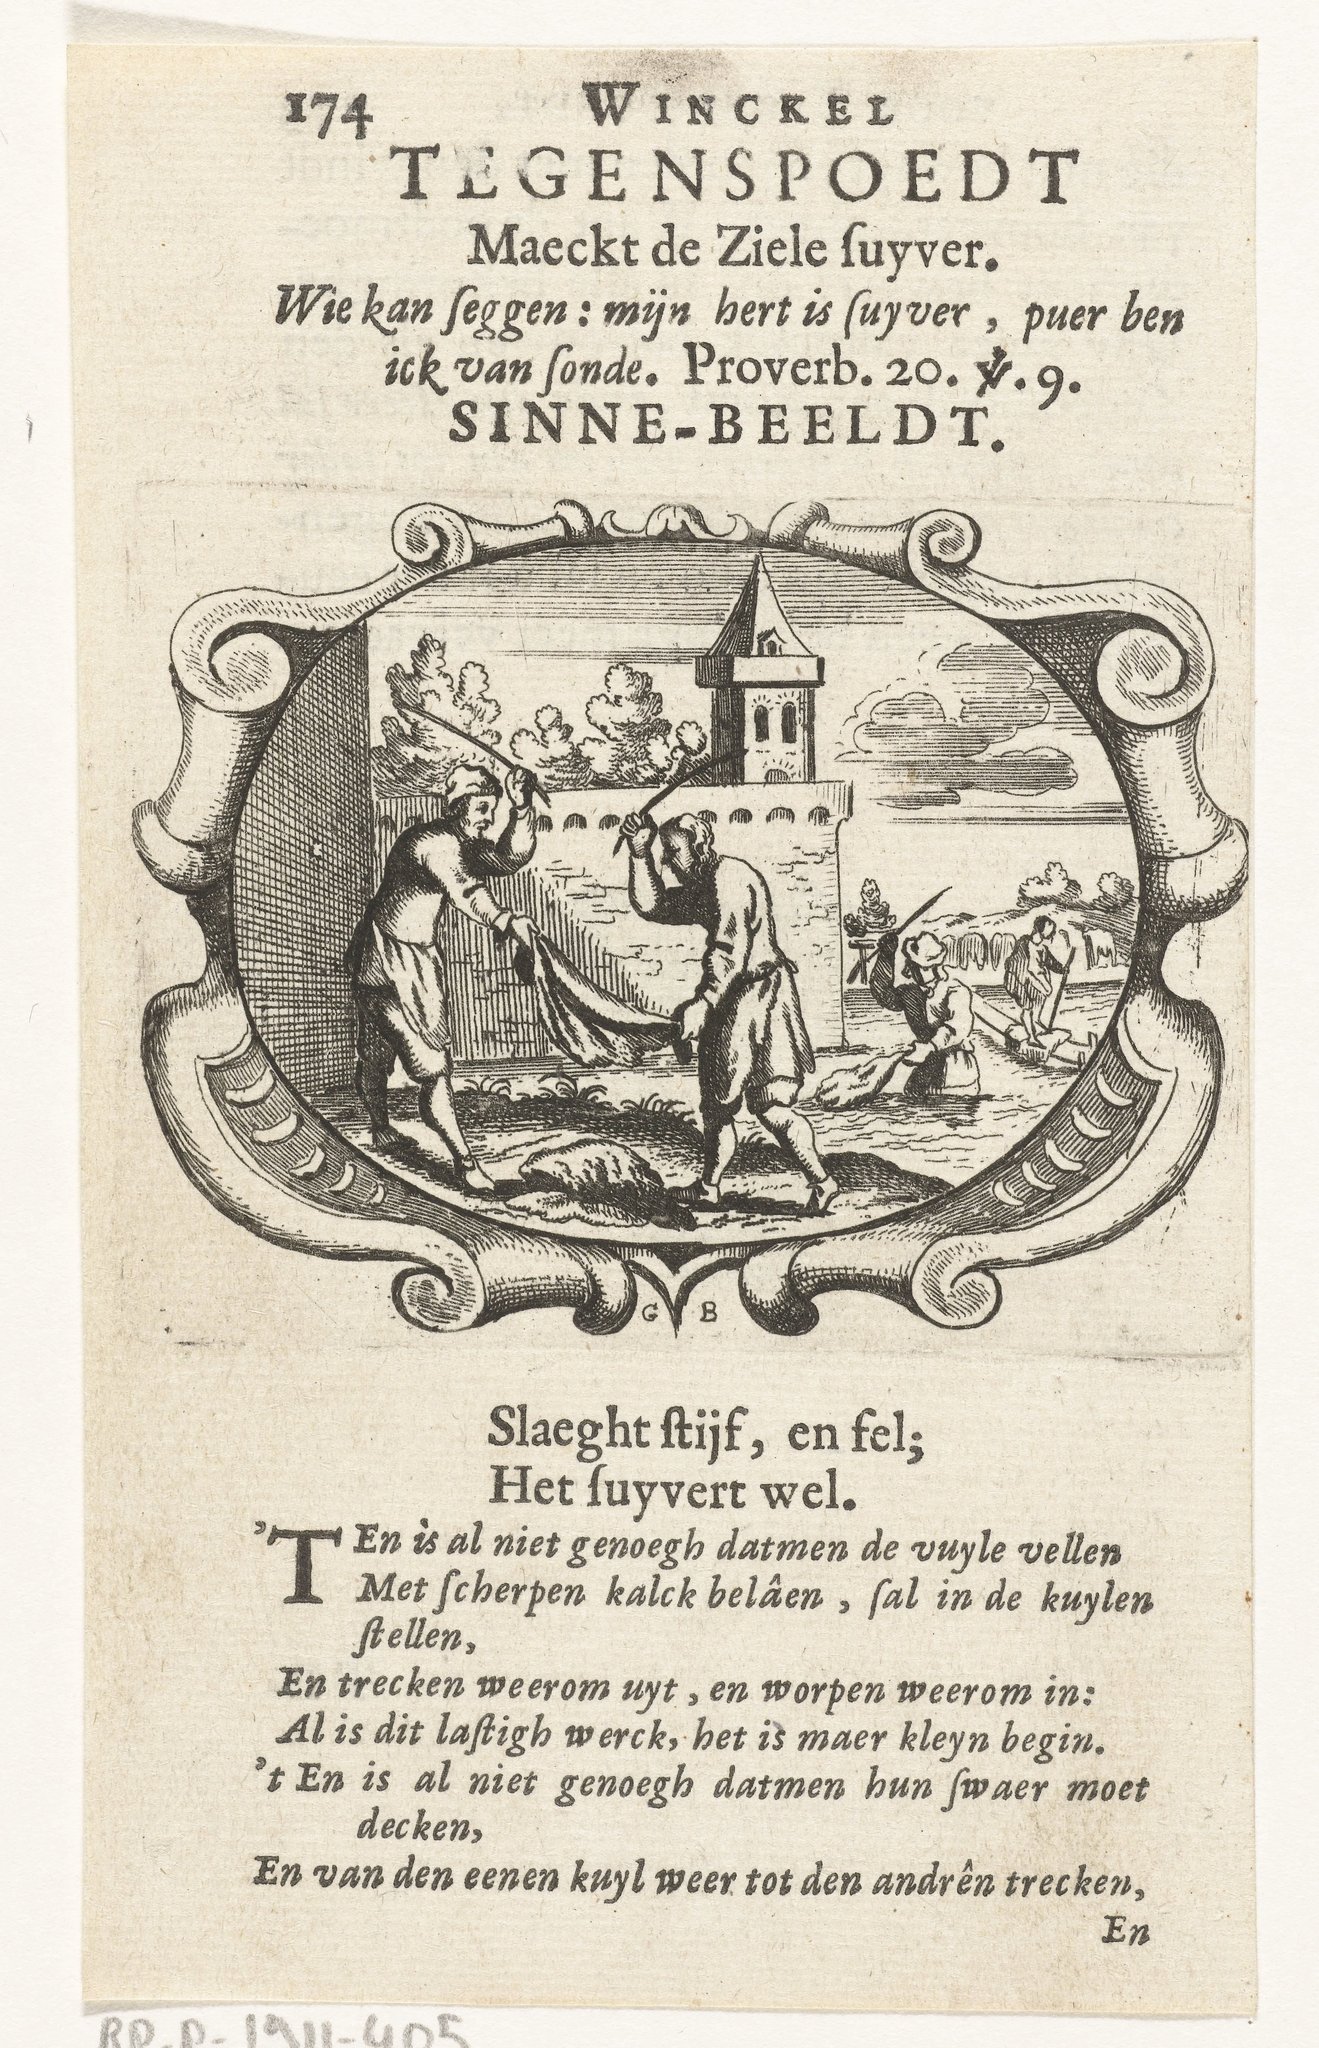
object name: print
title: Tegenspoedt maeckt de Ziele suyver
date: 1679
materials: paper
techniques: engraving, etching, letterpress printing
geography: diest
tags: the book of proverbs (with book chapter:verse), care of clothes, e.g.: brushing, beating, airing, adversity, misfortune, bad luck; 'fortuna infelice', 'infortunio' (ripa), laundering, abstract ideas and concepts (+ emblematical representation of concept)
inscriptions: collector's mark: Lugt 2228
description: Bladzijde uit een boek (p. 174) met tekst en drukkersvignet op verso. In een ovale cartouche de oever van een rivier. Op oever staan twee mannen die met stokken een stuk stof slaan dat ze beiden vasthebben. Op de achtergrond staat een man in de rivier. Ook hij slaat met een stok op een stuk stof. Een andere man vaart met een bootje voorbij. Boven de cartouche de titel (motto) van de prent en een citaat uit de bijbel (Spreuken 20:9). Onder de prent een onderschrift: 'Slaeght stijf, en fel; Het suyvert wel.' en een beschrijving die de prent verklaart. Om vuile doeken goed te wassen moeten ze hard bewerkt worden. Vergelijkbaar moet de mens hard behandeld worden zodat zijn ziel zuiver wordt.